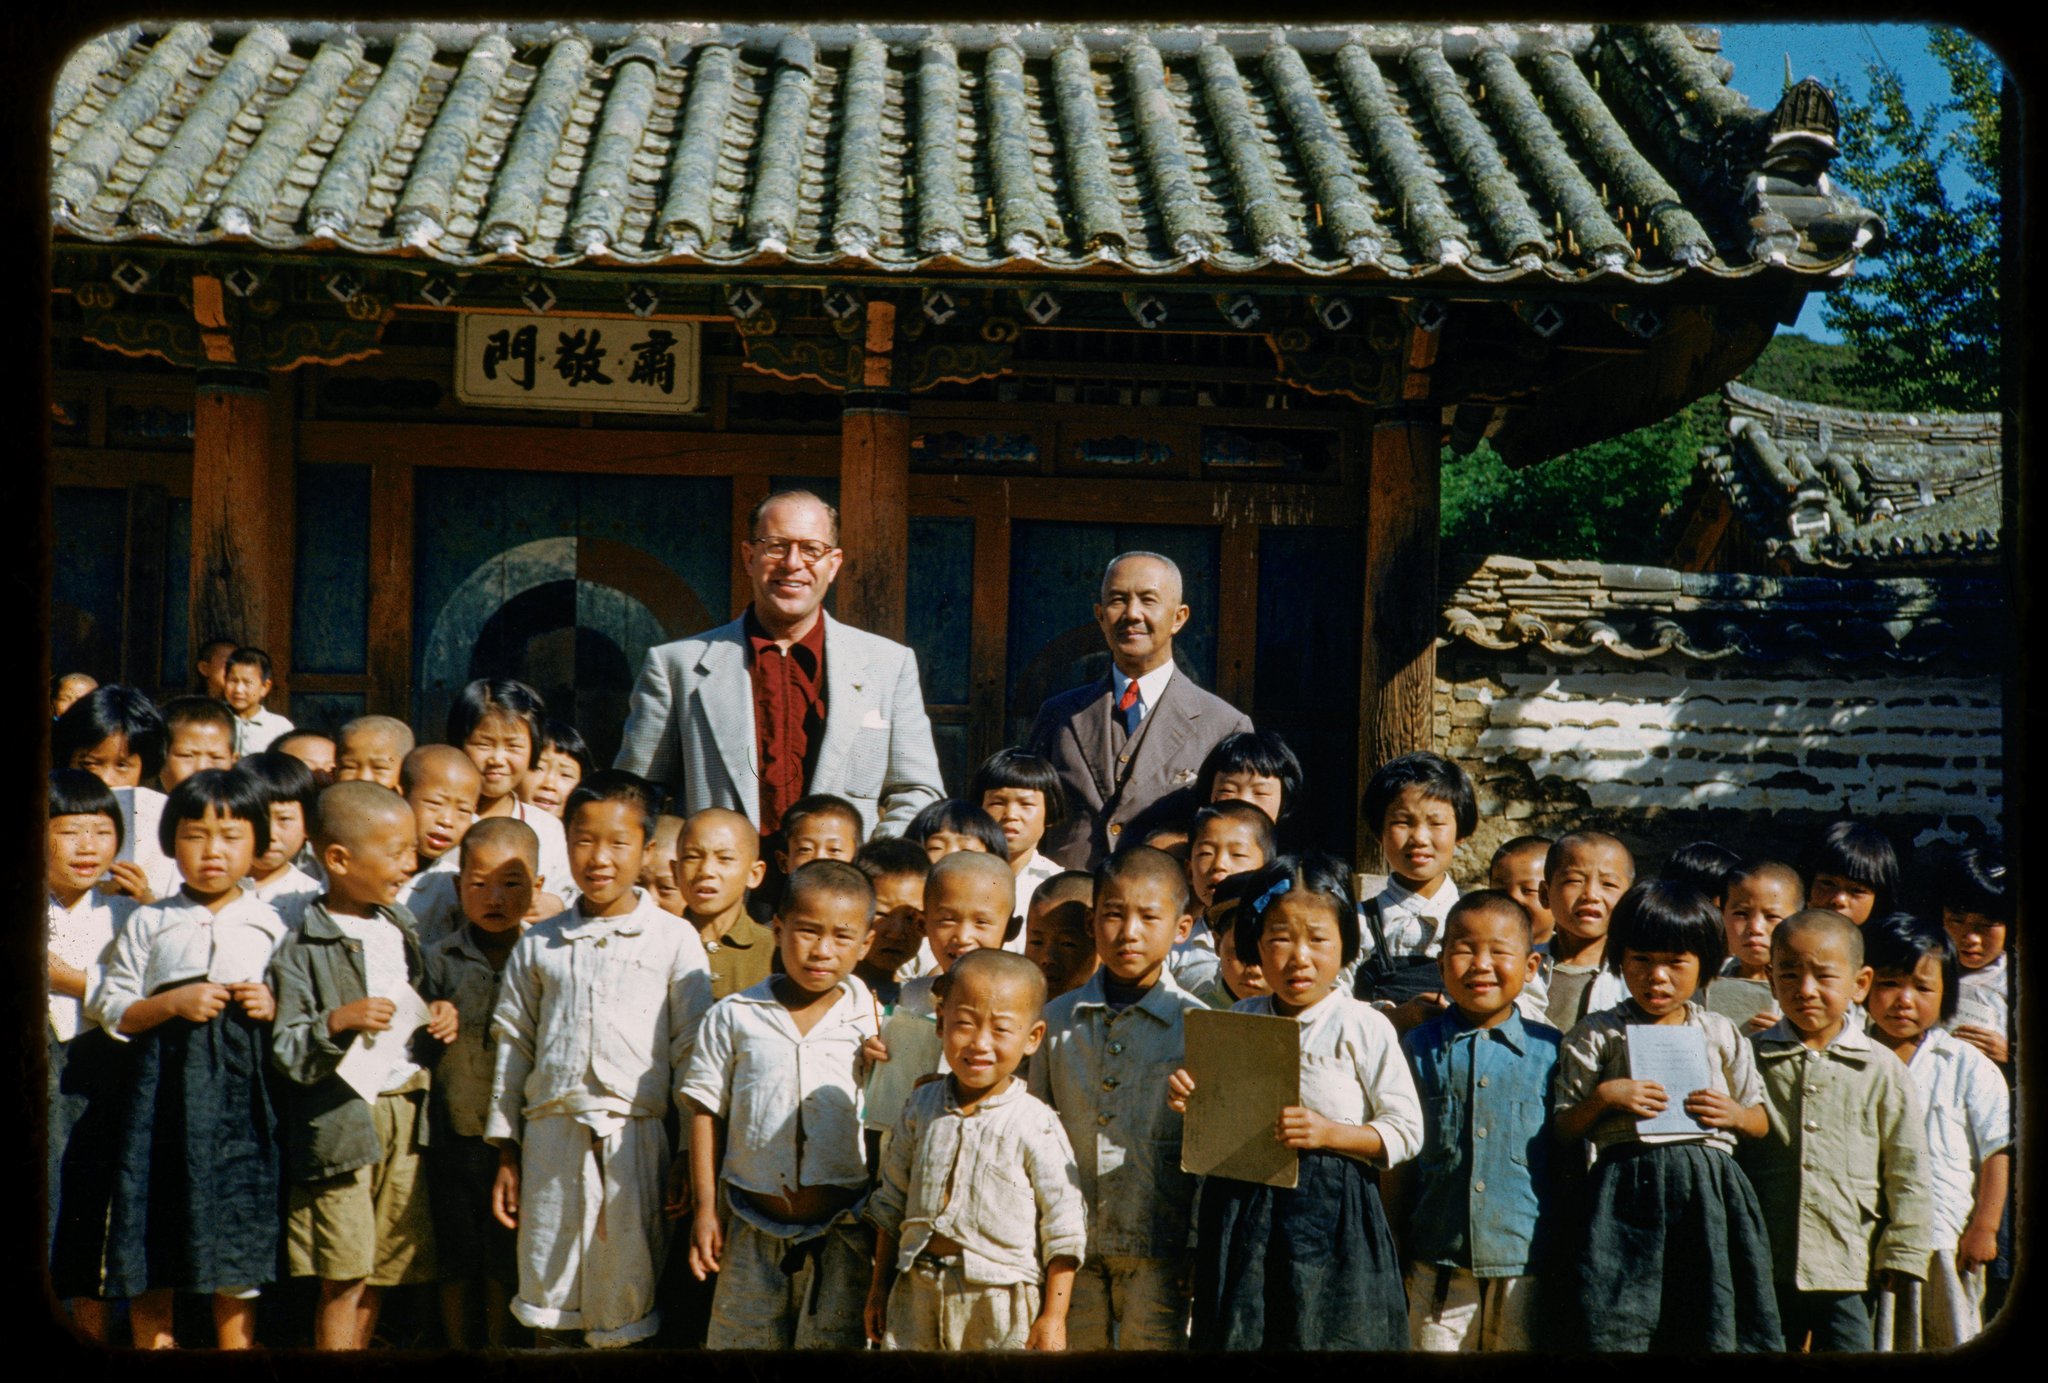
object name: color slide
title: David Ketel met de Koreaanse Prins Fridi bij een tempel-school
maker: david ketel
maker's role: diplomaat, sinoloog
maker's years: 1913-2008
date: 1952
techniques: slide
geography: korea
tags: united nations